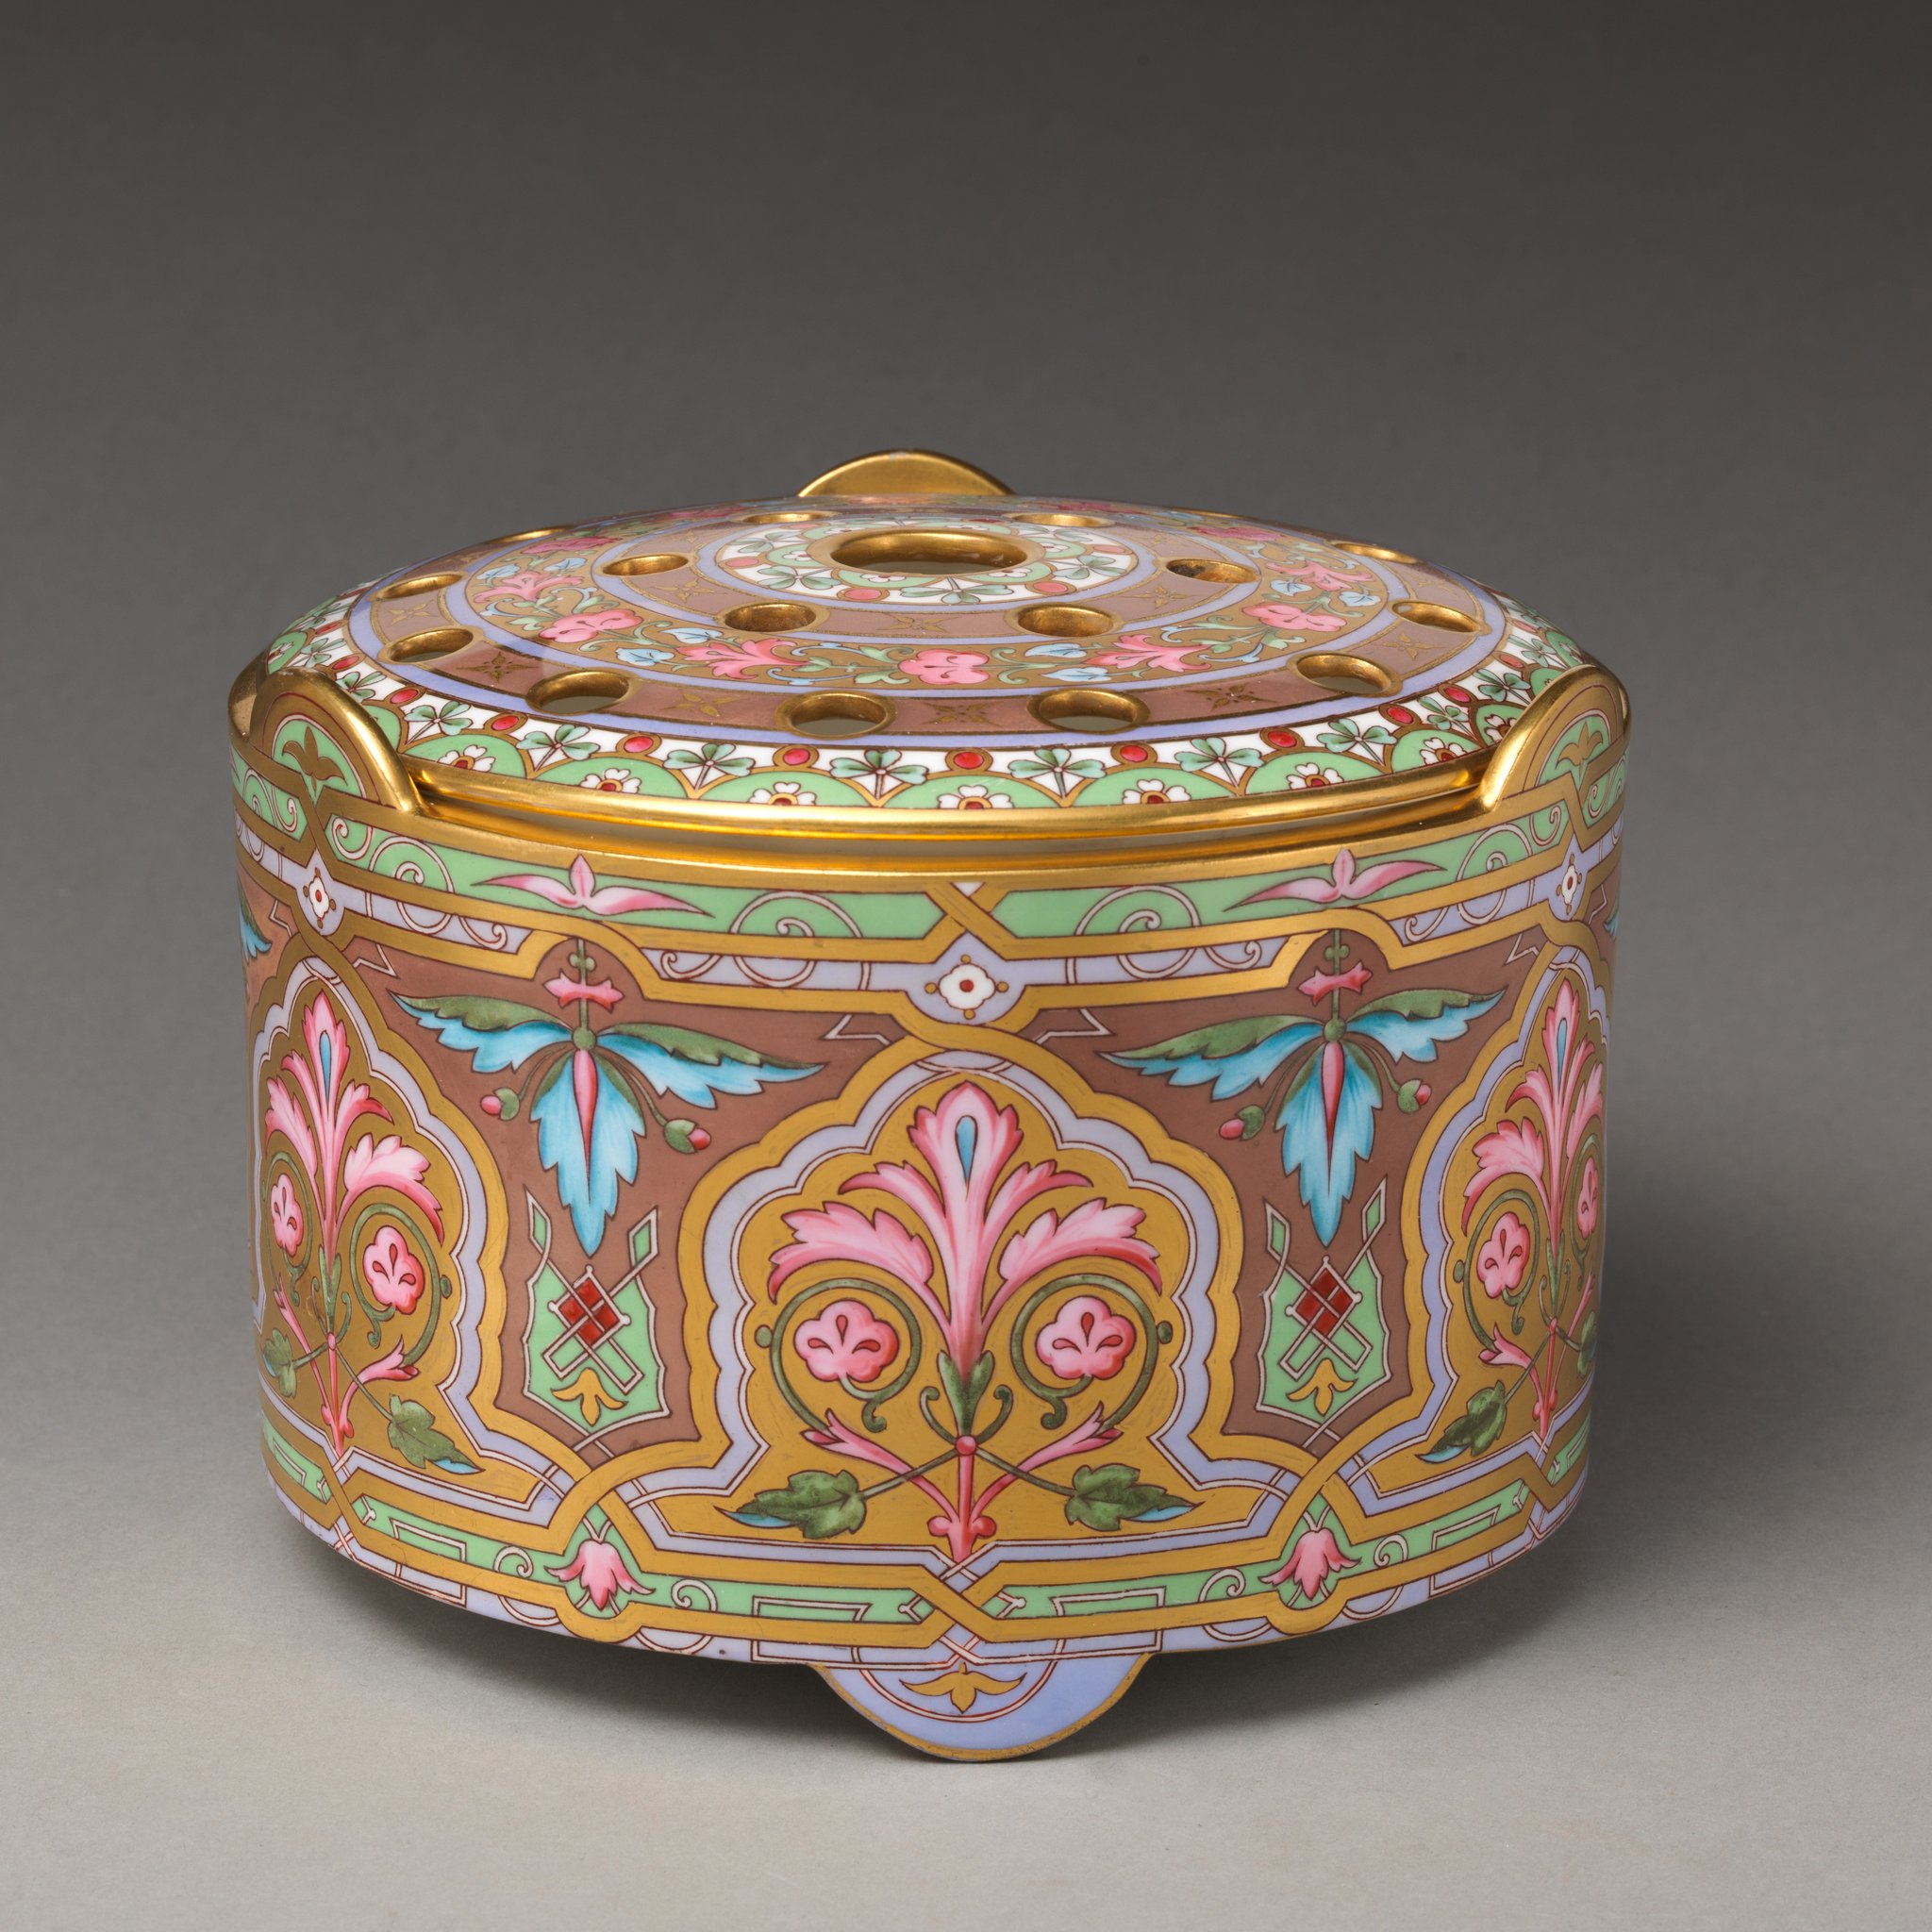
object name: potpourri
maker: minton(s)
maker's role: maker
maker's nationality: british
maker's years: 1793-2001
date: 1875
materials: bone china